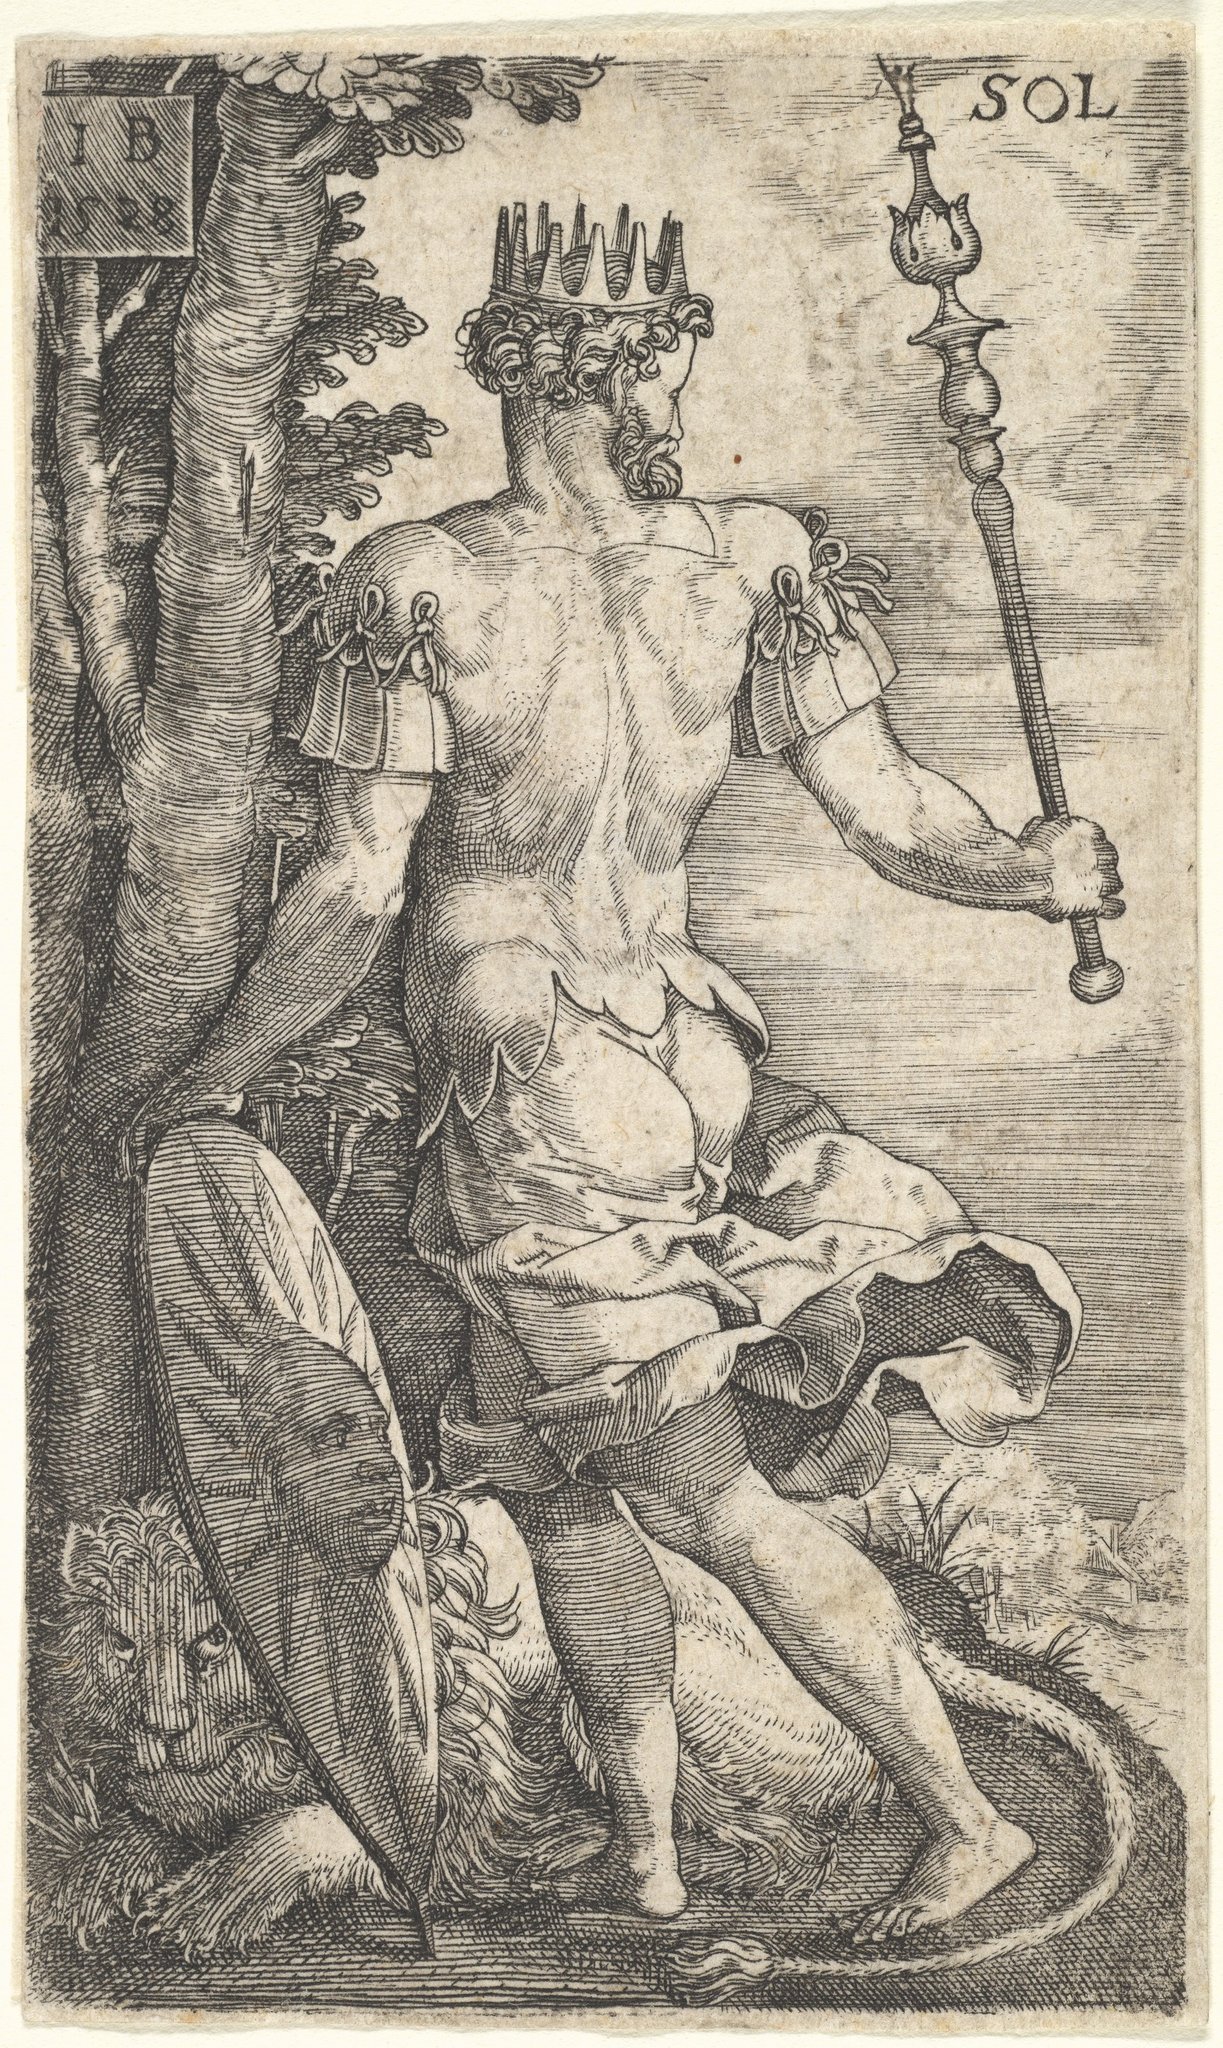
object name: print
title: Sun, from "The Gods Who Preside Over the Planets"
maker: master i.b.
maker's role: artist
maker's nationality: german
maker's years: 1525-1530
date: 1528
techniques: etching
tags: shields,weapons,lions